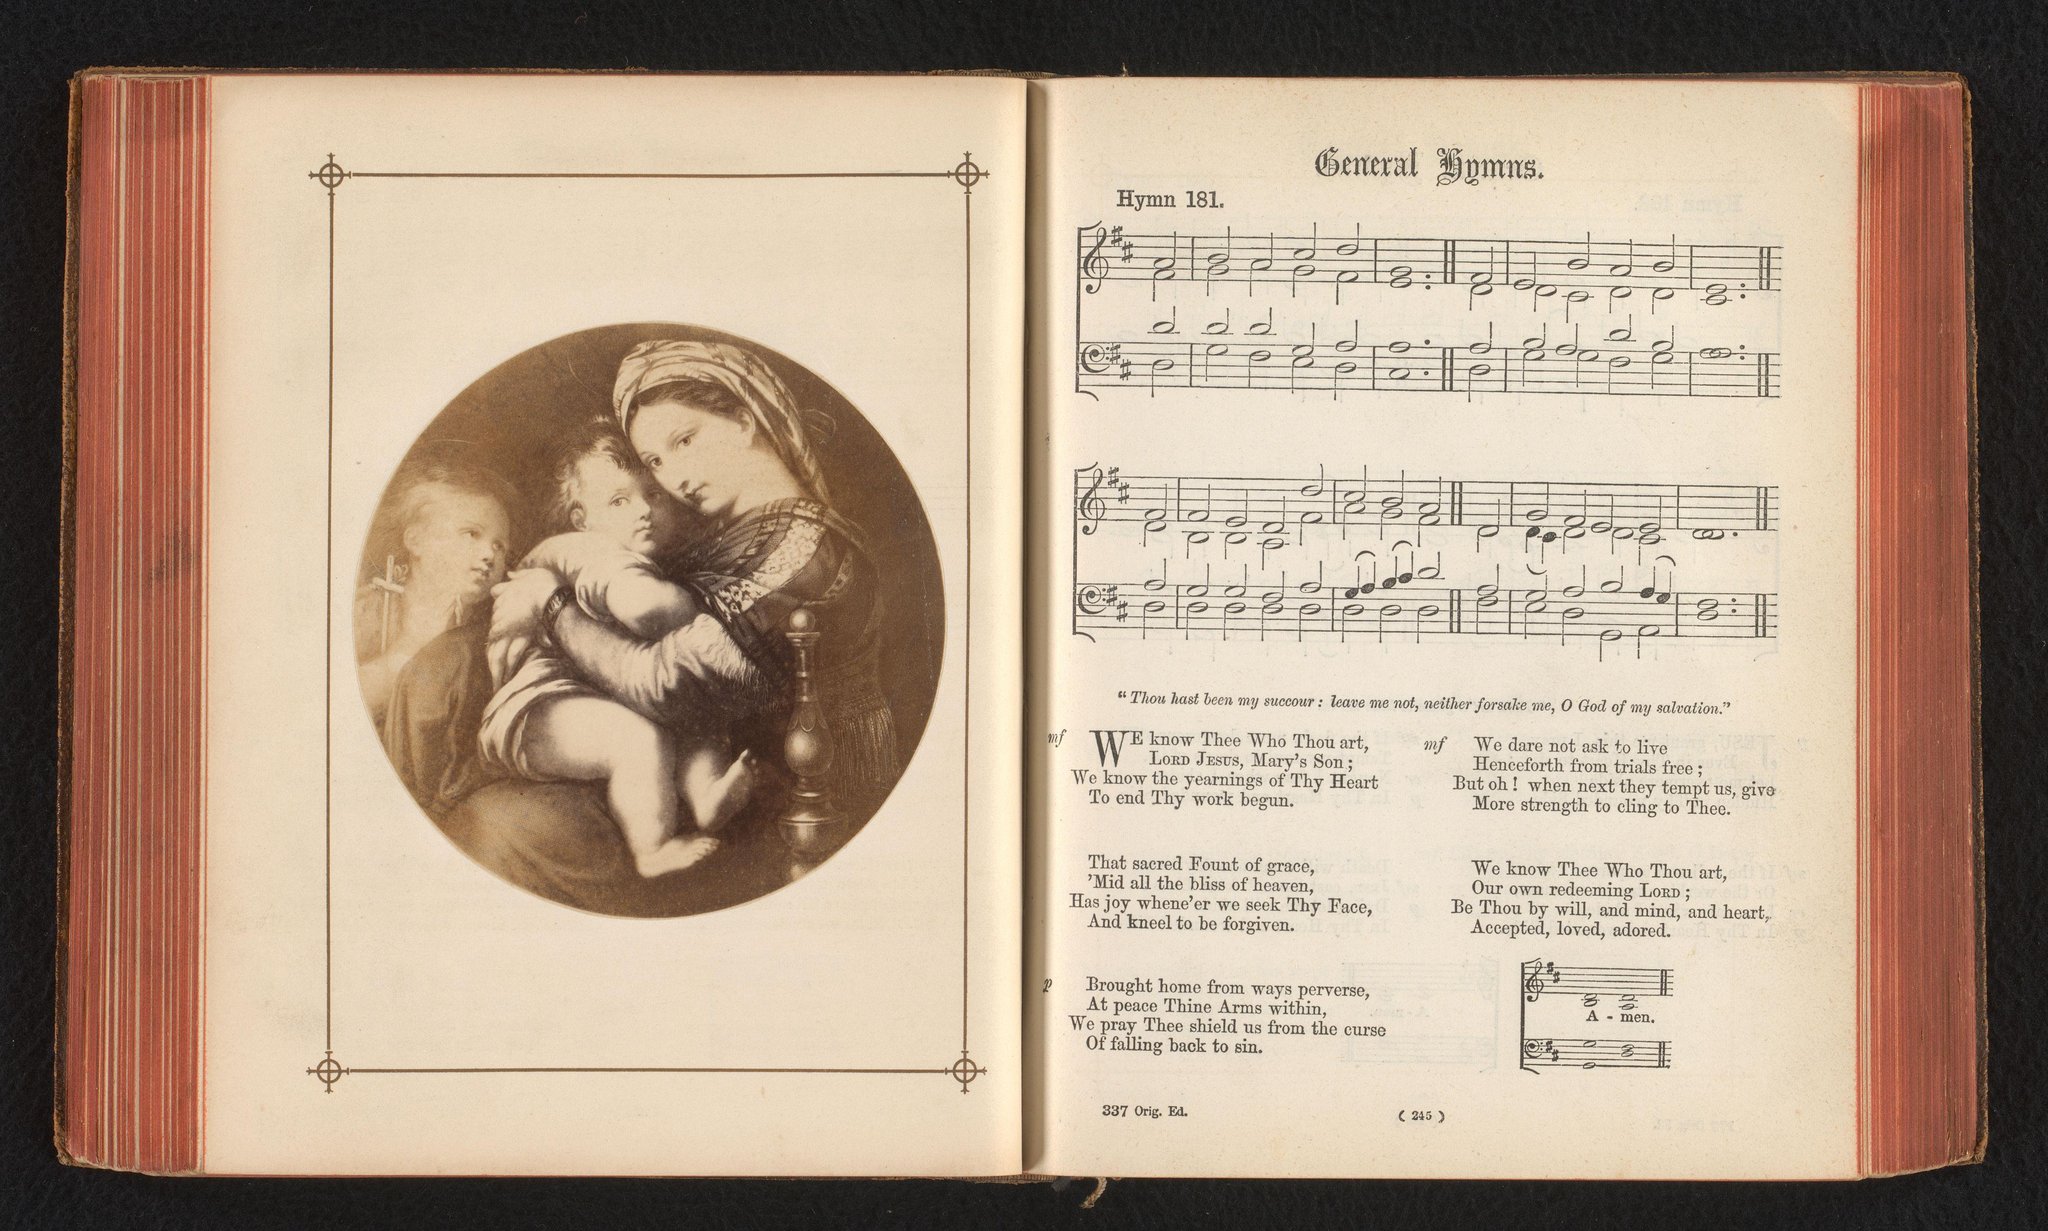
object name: page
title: Fotoreproductie van het schilderij Madonna met de stoel door Rafaël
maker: Anonymous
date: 1866-1876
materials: paper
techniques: albumen print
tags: madonna: i.e. mary with the christ-child, picture, painting